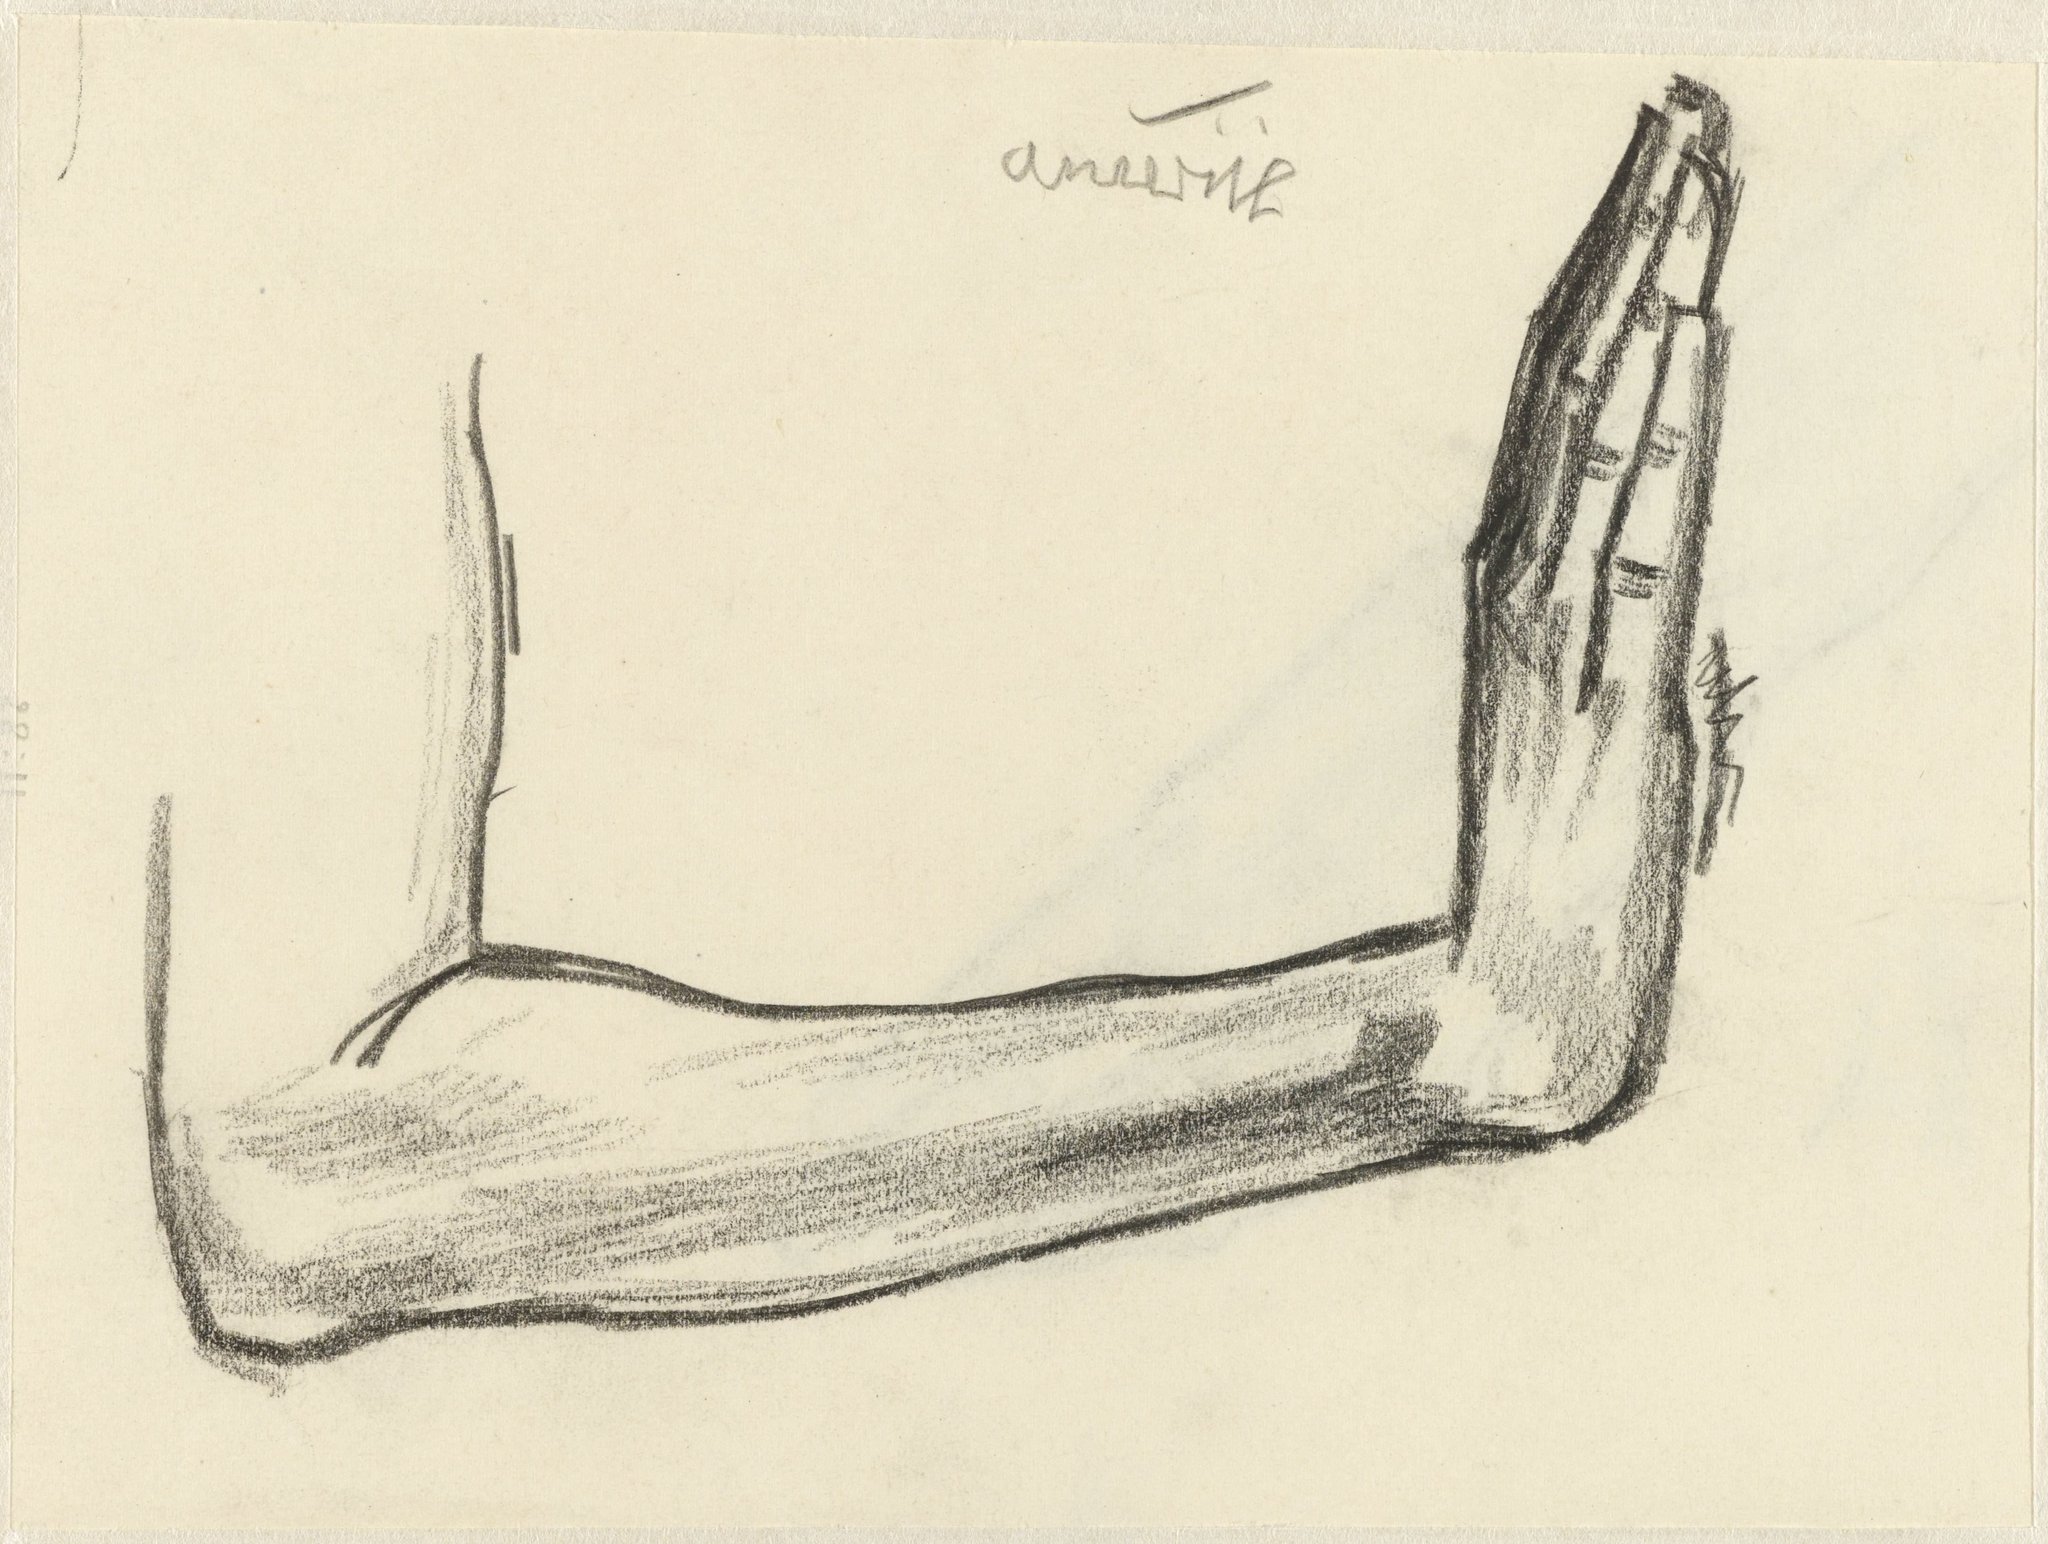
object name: drawing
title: Studie van een onderarm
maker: jan toorop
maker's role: draughtsman, painter, print maker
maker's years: 1858-1928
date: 1868-1928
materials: chalk, paper